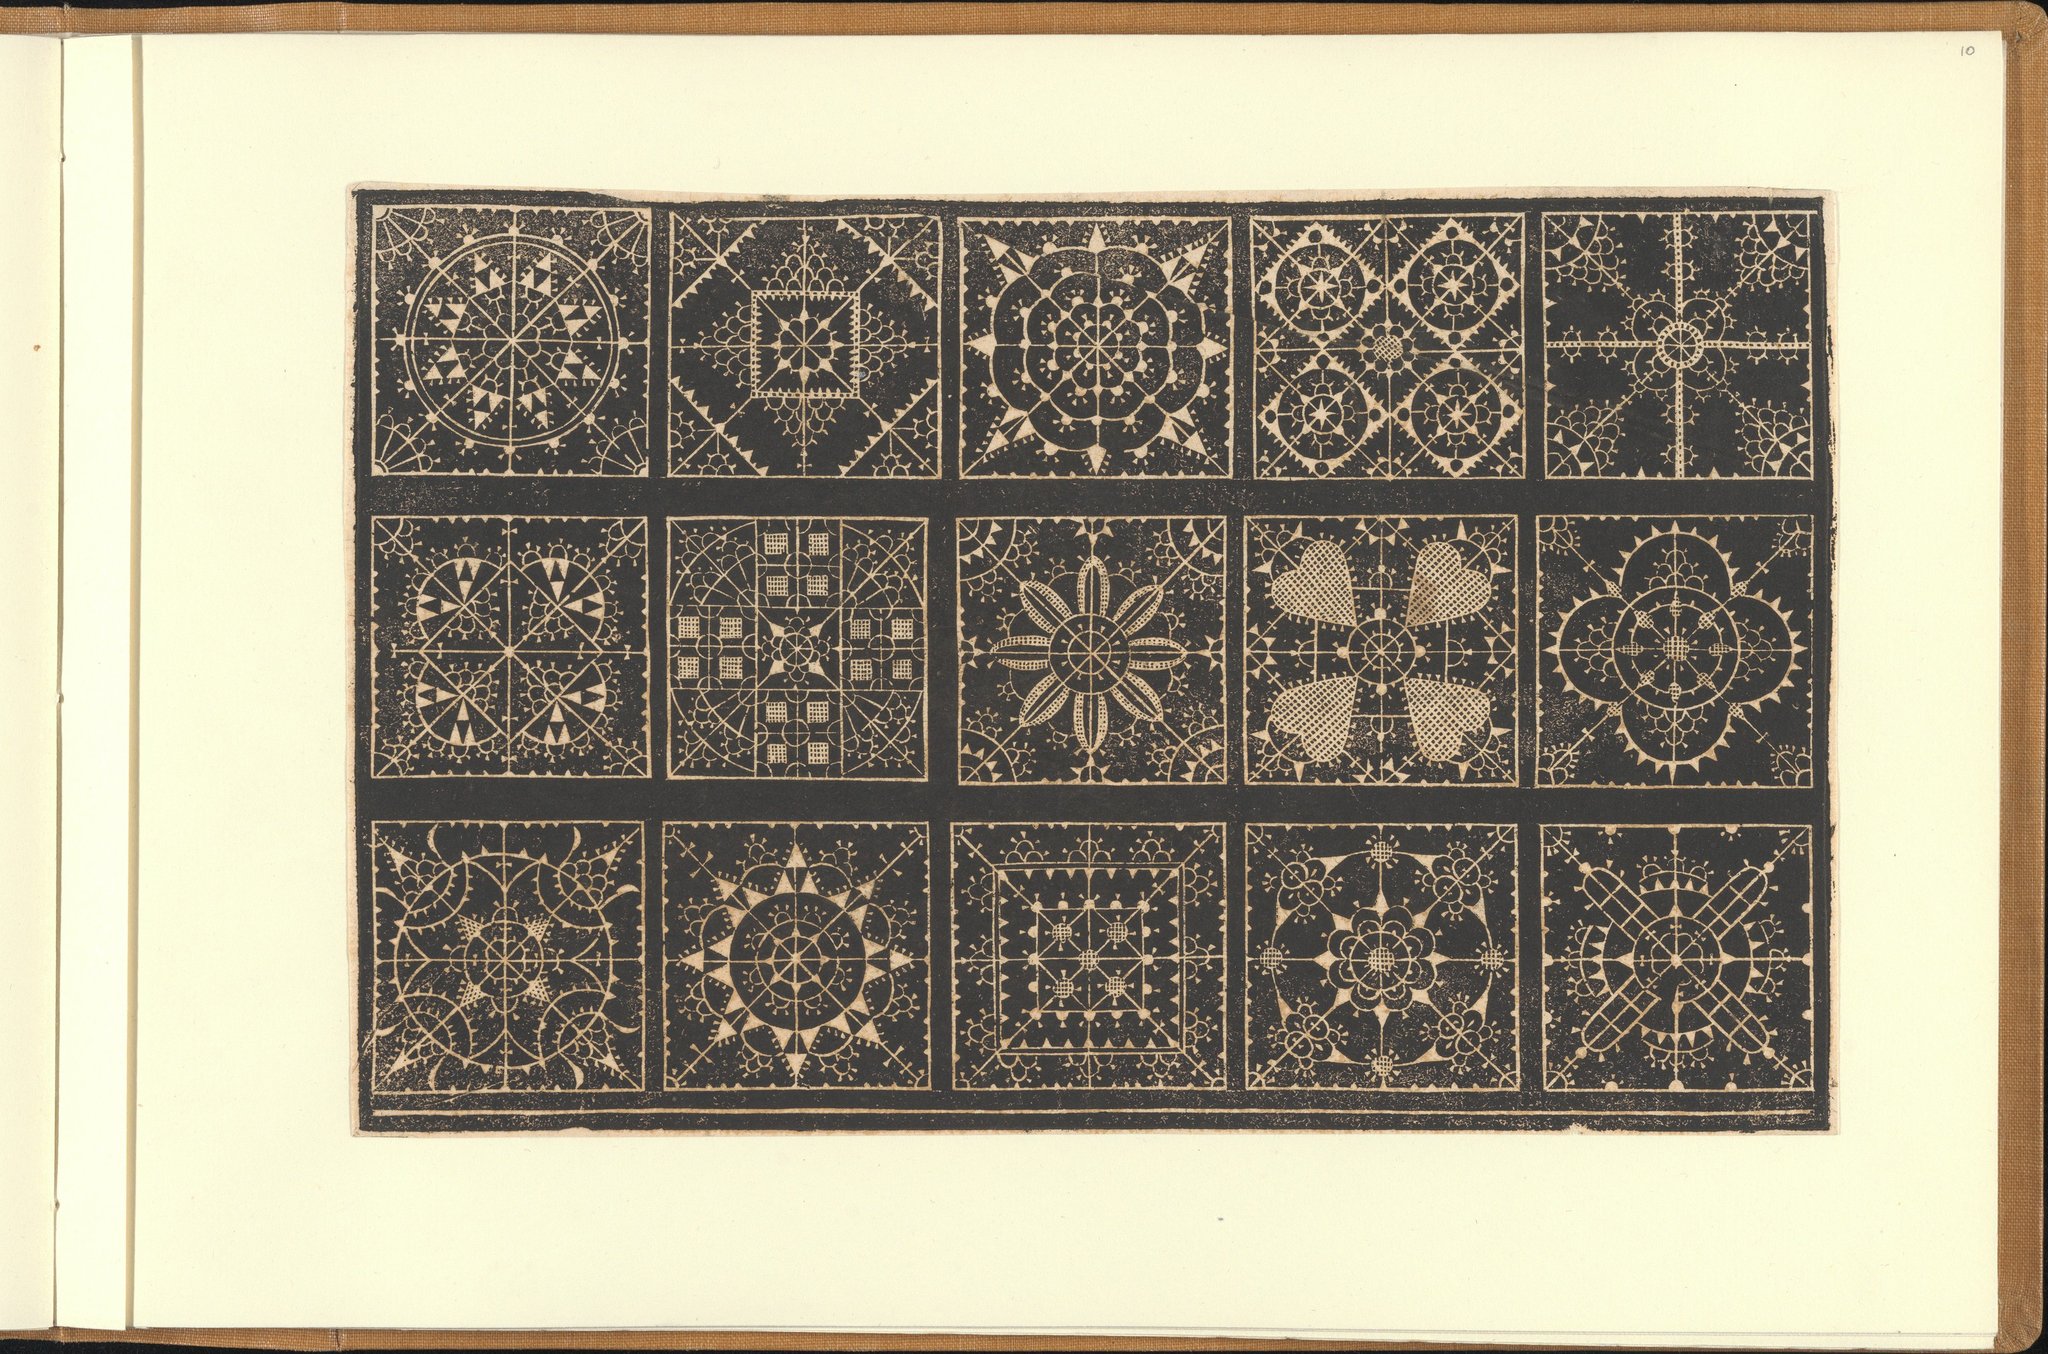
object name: album print ornament architecture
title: Schon newes Modelbuch...Page 10(r)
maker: sigismundus latomus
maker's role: designer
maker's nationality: german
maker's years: 1599-1632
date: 1617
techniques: woodcut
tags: ornament